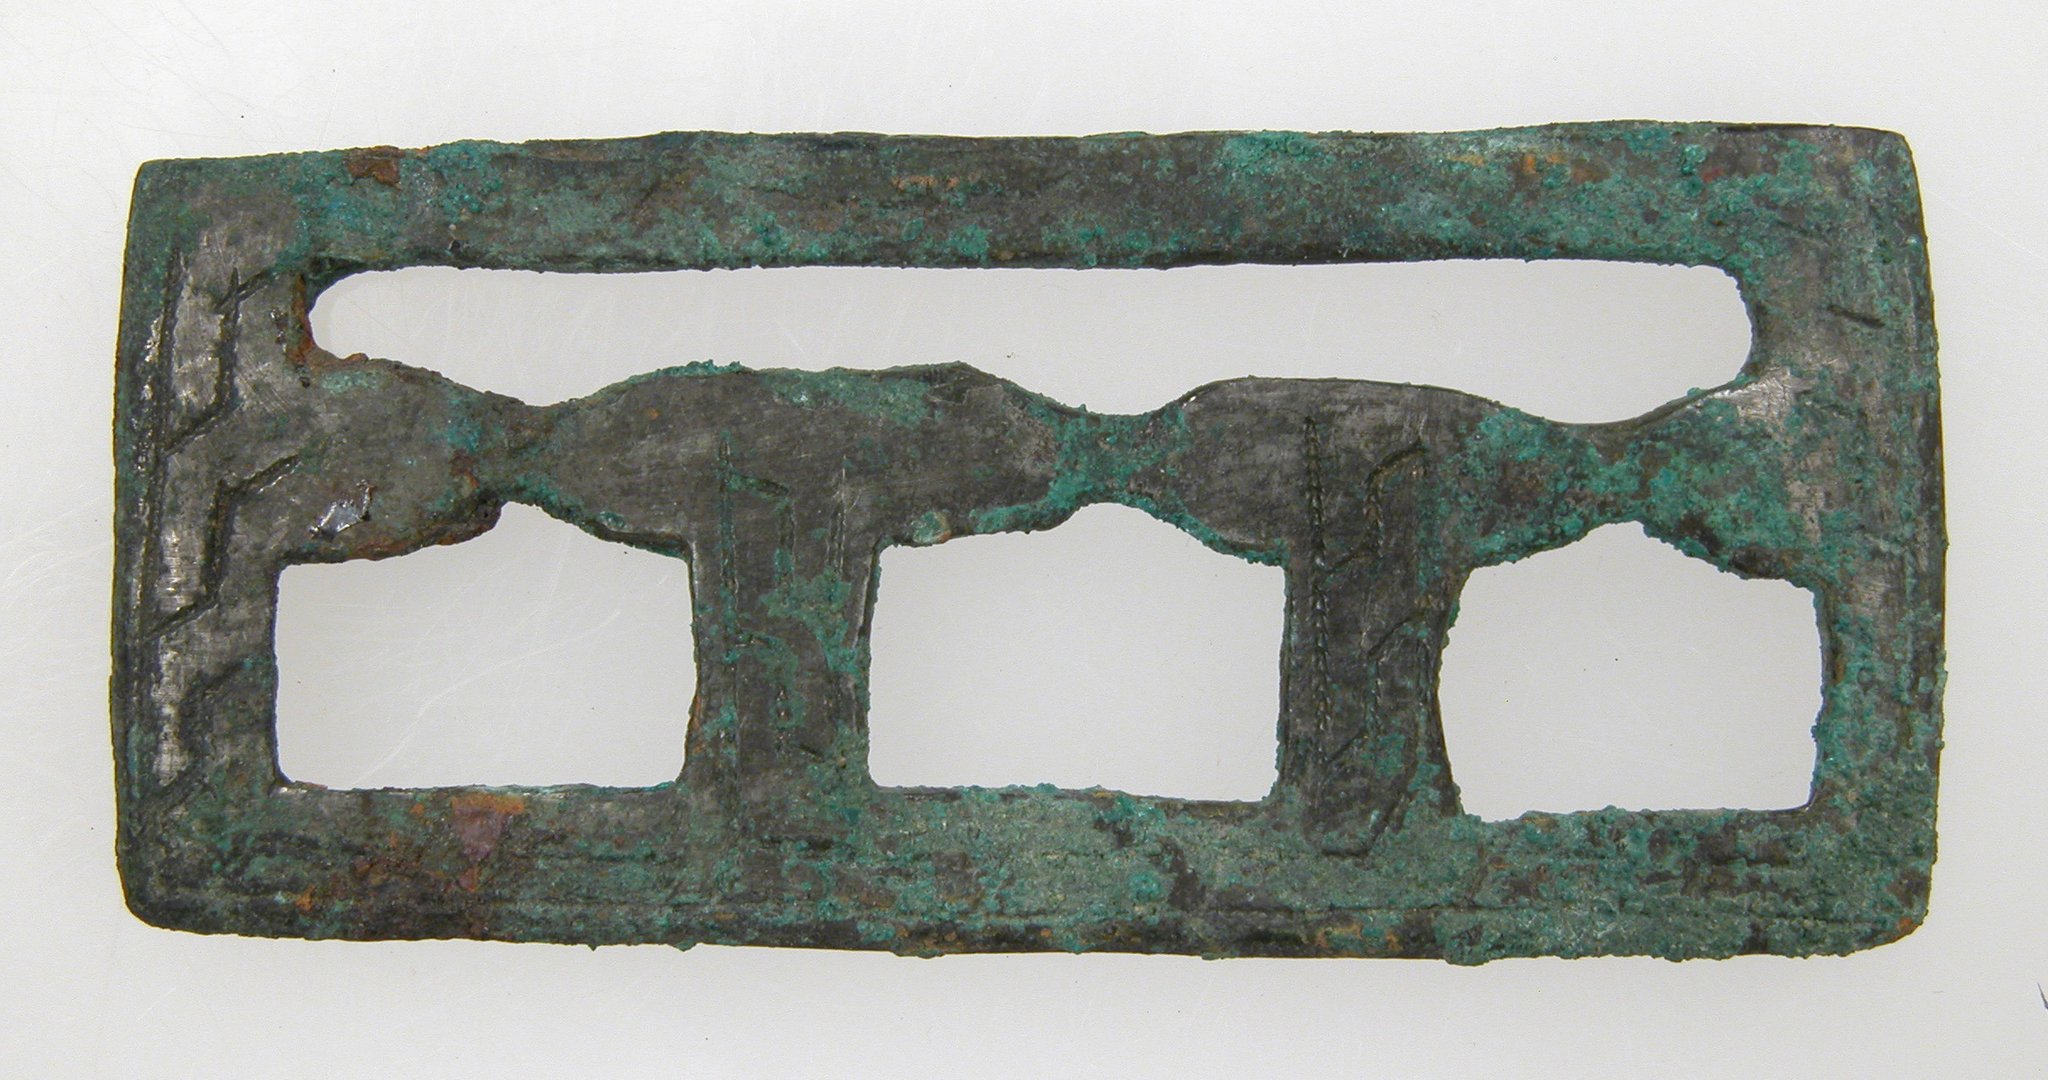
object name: plaque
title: Openwork Plaque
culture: frankish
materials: copper alloy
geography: northern france